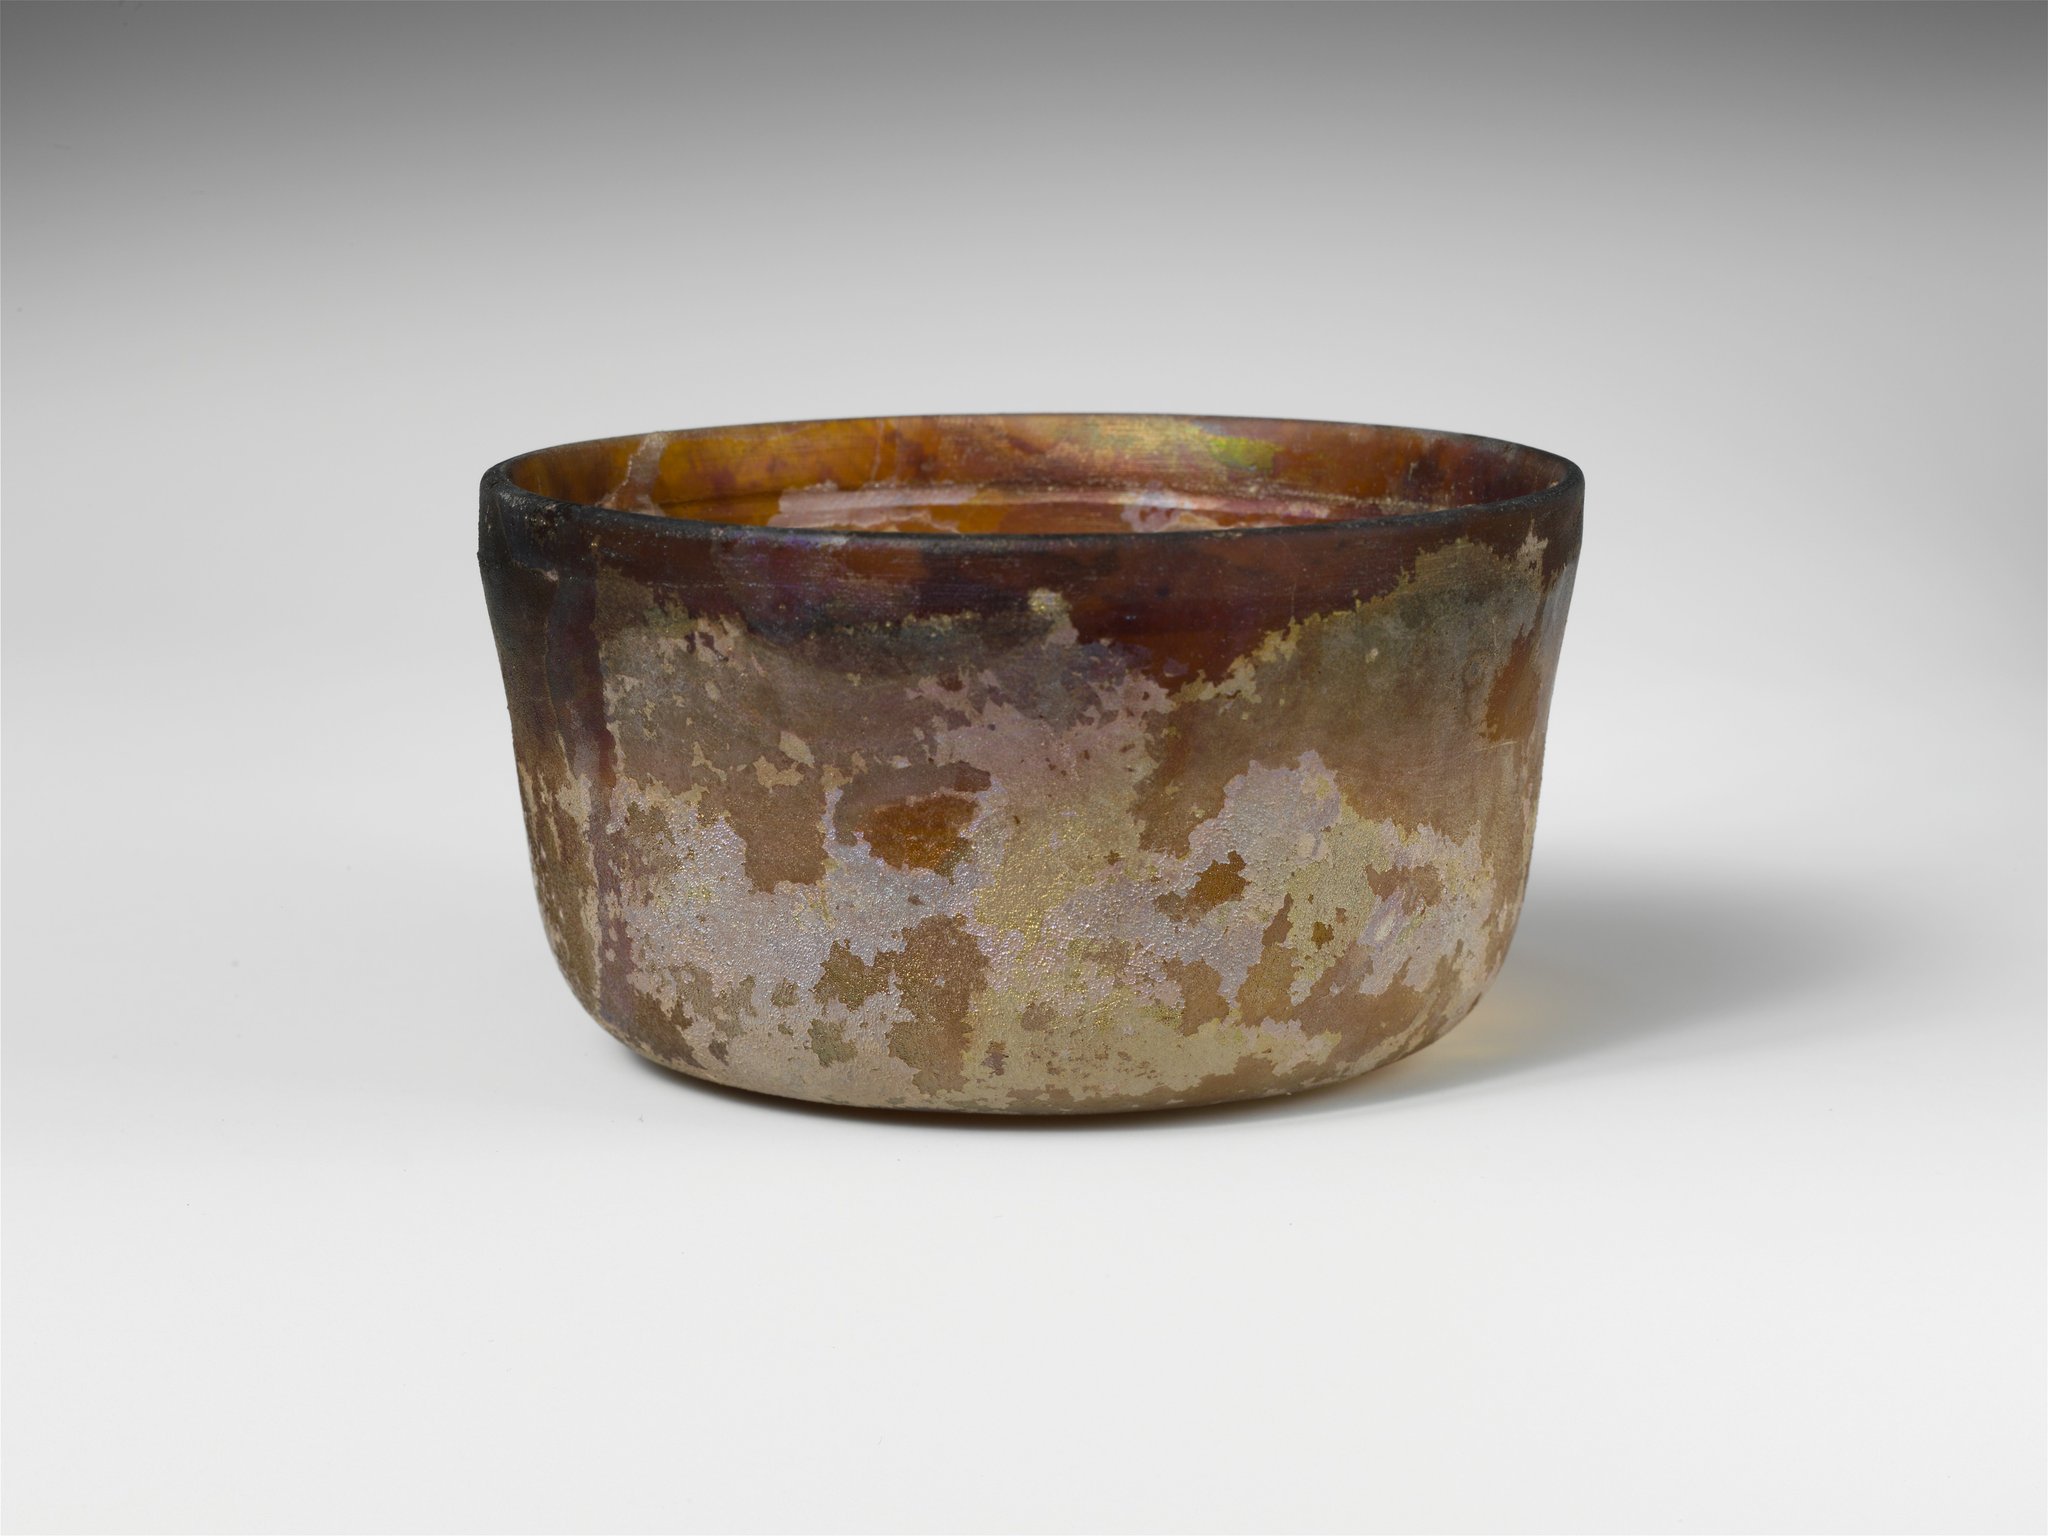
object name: bowl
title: Glass bowl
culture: roman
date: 34 BCE-33 CE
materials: glass